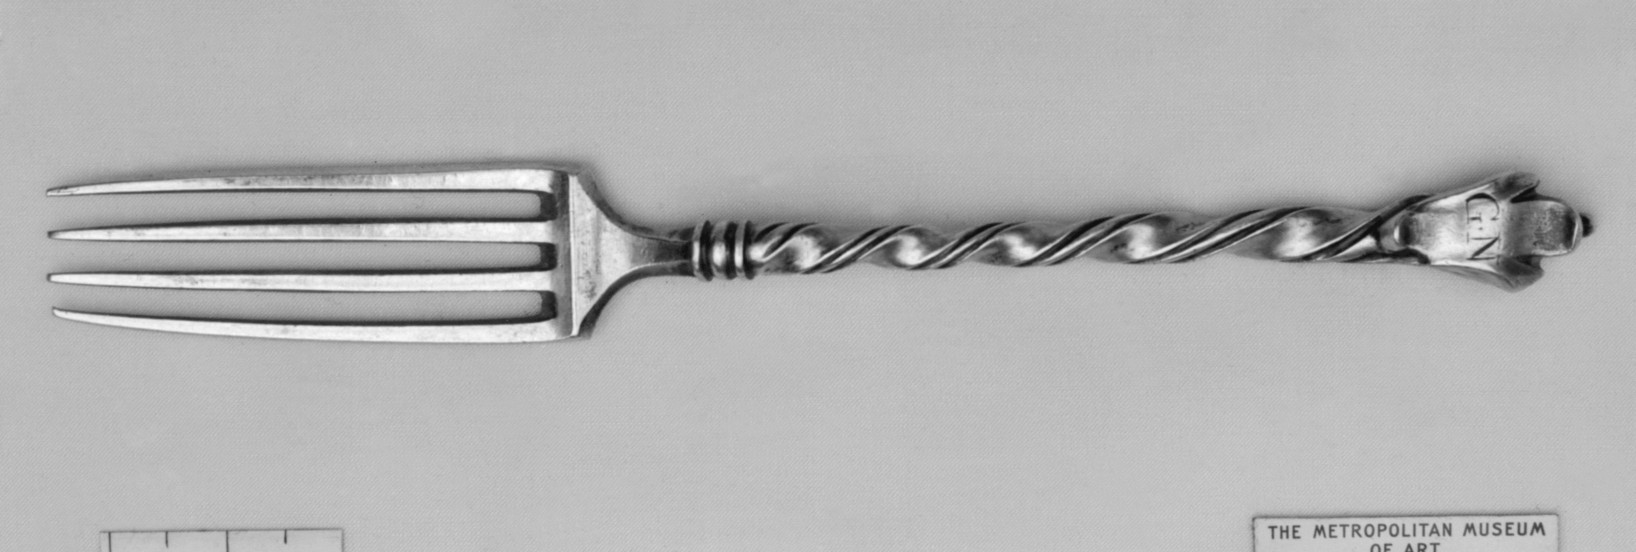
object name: fork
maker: girolamo maltraversi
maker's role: maker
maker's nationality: italian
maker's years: 1698-1730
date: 1700-1730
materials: silver